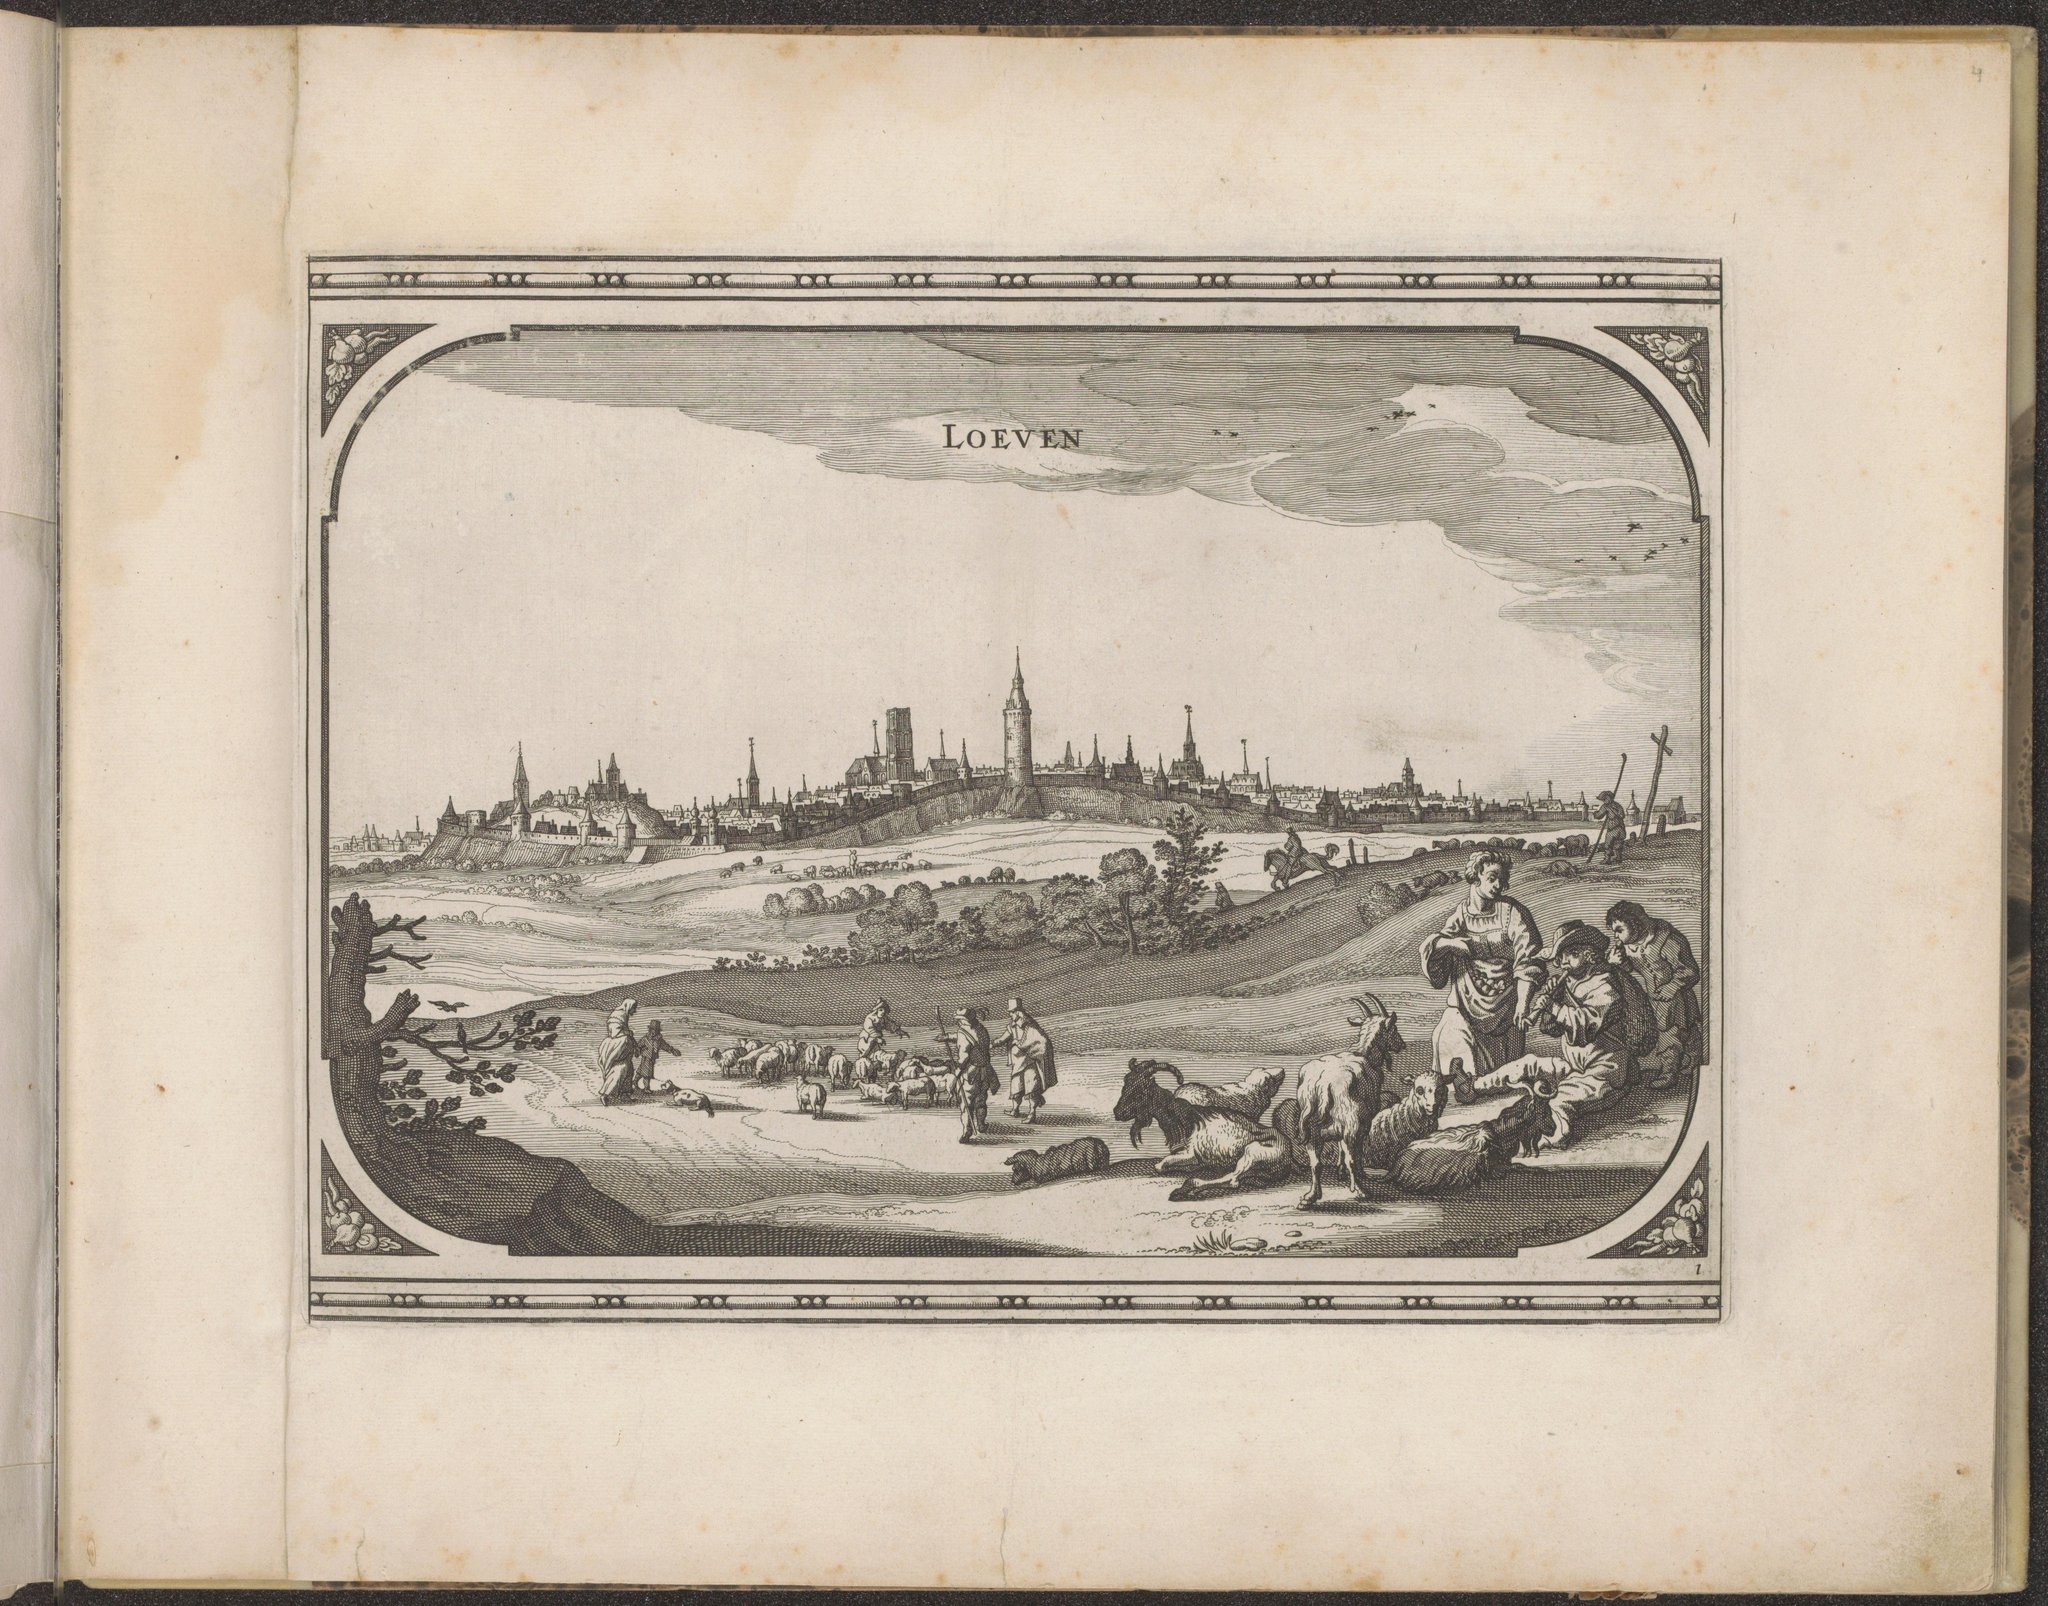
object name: print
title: Loeven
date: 1660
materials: paper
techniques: etching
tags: city-view, and landscape with man-made constructions, herding, herdsman, herdswoman, shepherd, shepherdess, cowherd, etc., louvain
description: Gezicht op de stad Leuven. Op de voorgrond enkele herders. Rechts speelt een man op een fluit. Naast hem heeft een vrouw appels of pruimen in de schort van haar jurk. Een jongen neemt een hap van één van de vruchten. De prent maakt deel uit van een album.